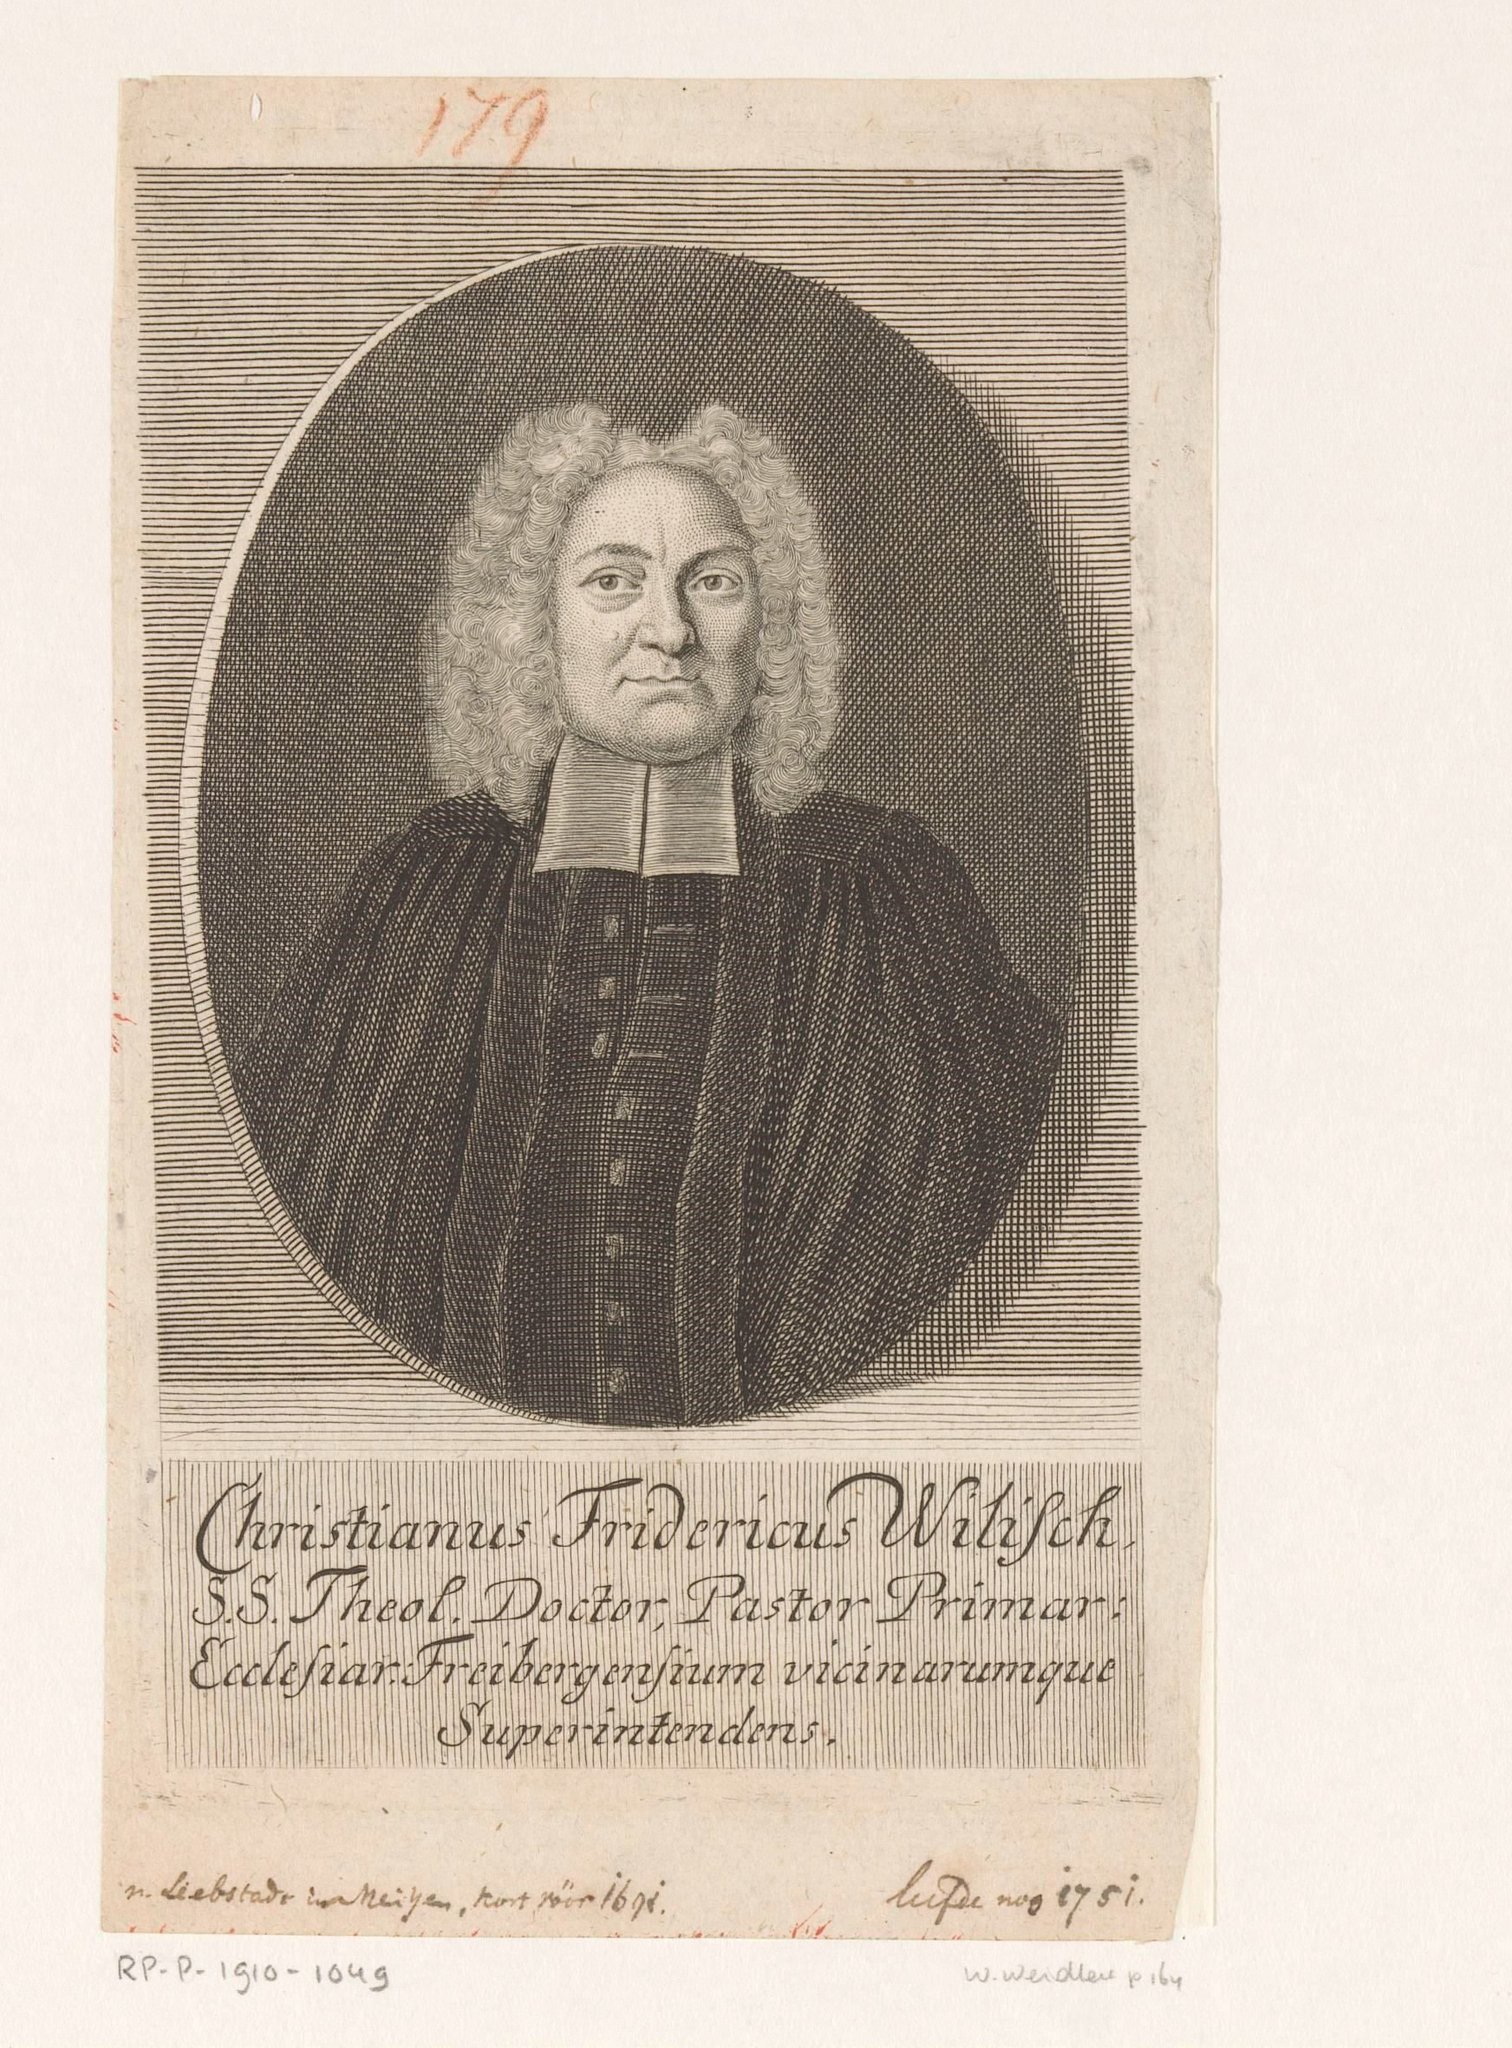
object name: print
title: Portret van Christian Friedrich Wilisch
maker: johann martin bernigeroth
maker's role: print maker, publisher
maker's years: 1713-1767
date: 1731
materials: paper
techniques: engraving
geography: leipzig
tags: christian friedrich wilisch, historical persons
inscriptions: collector's mark: Lugt 2228